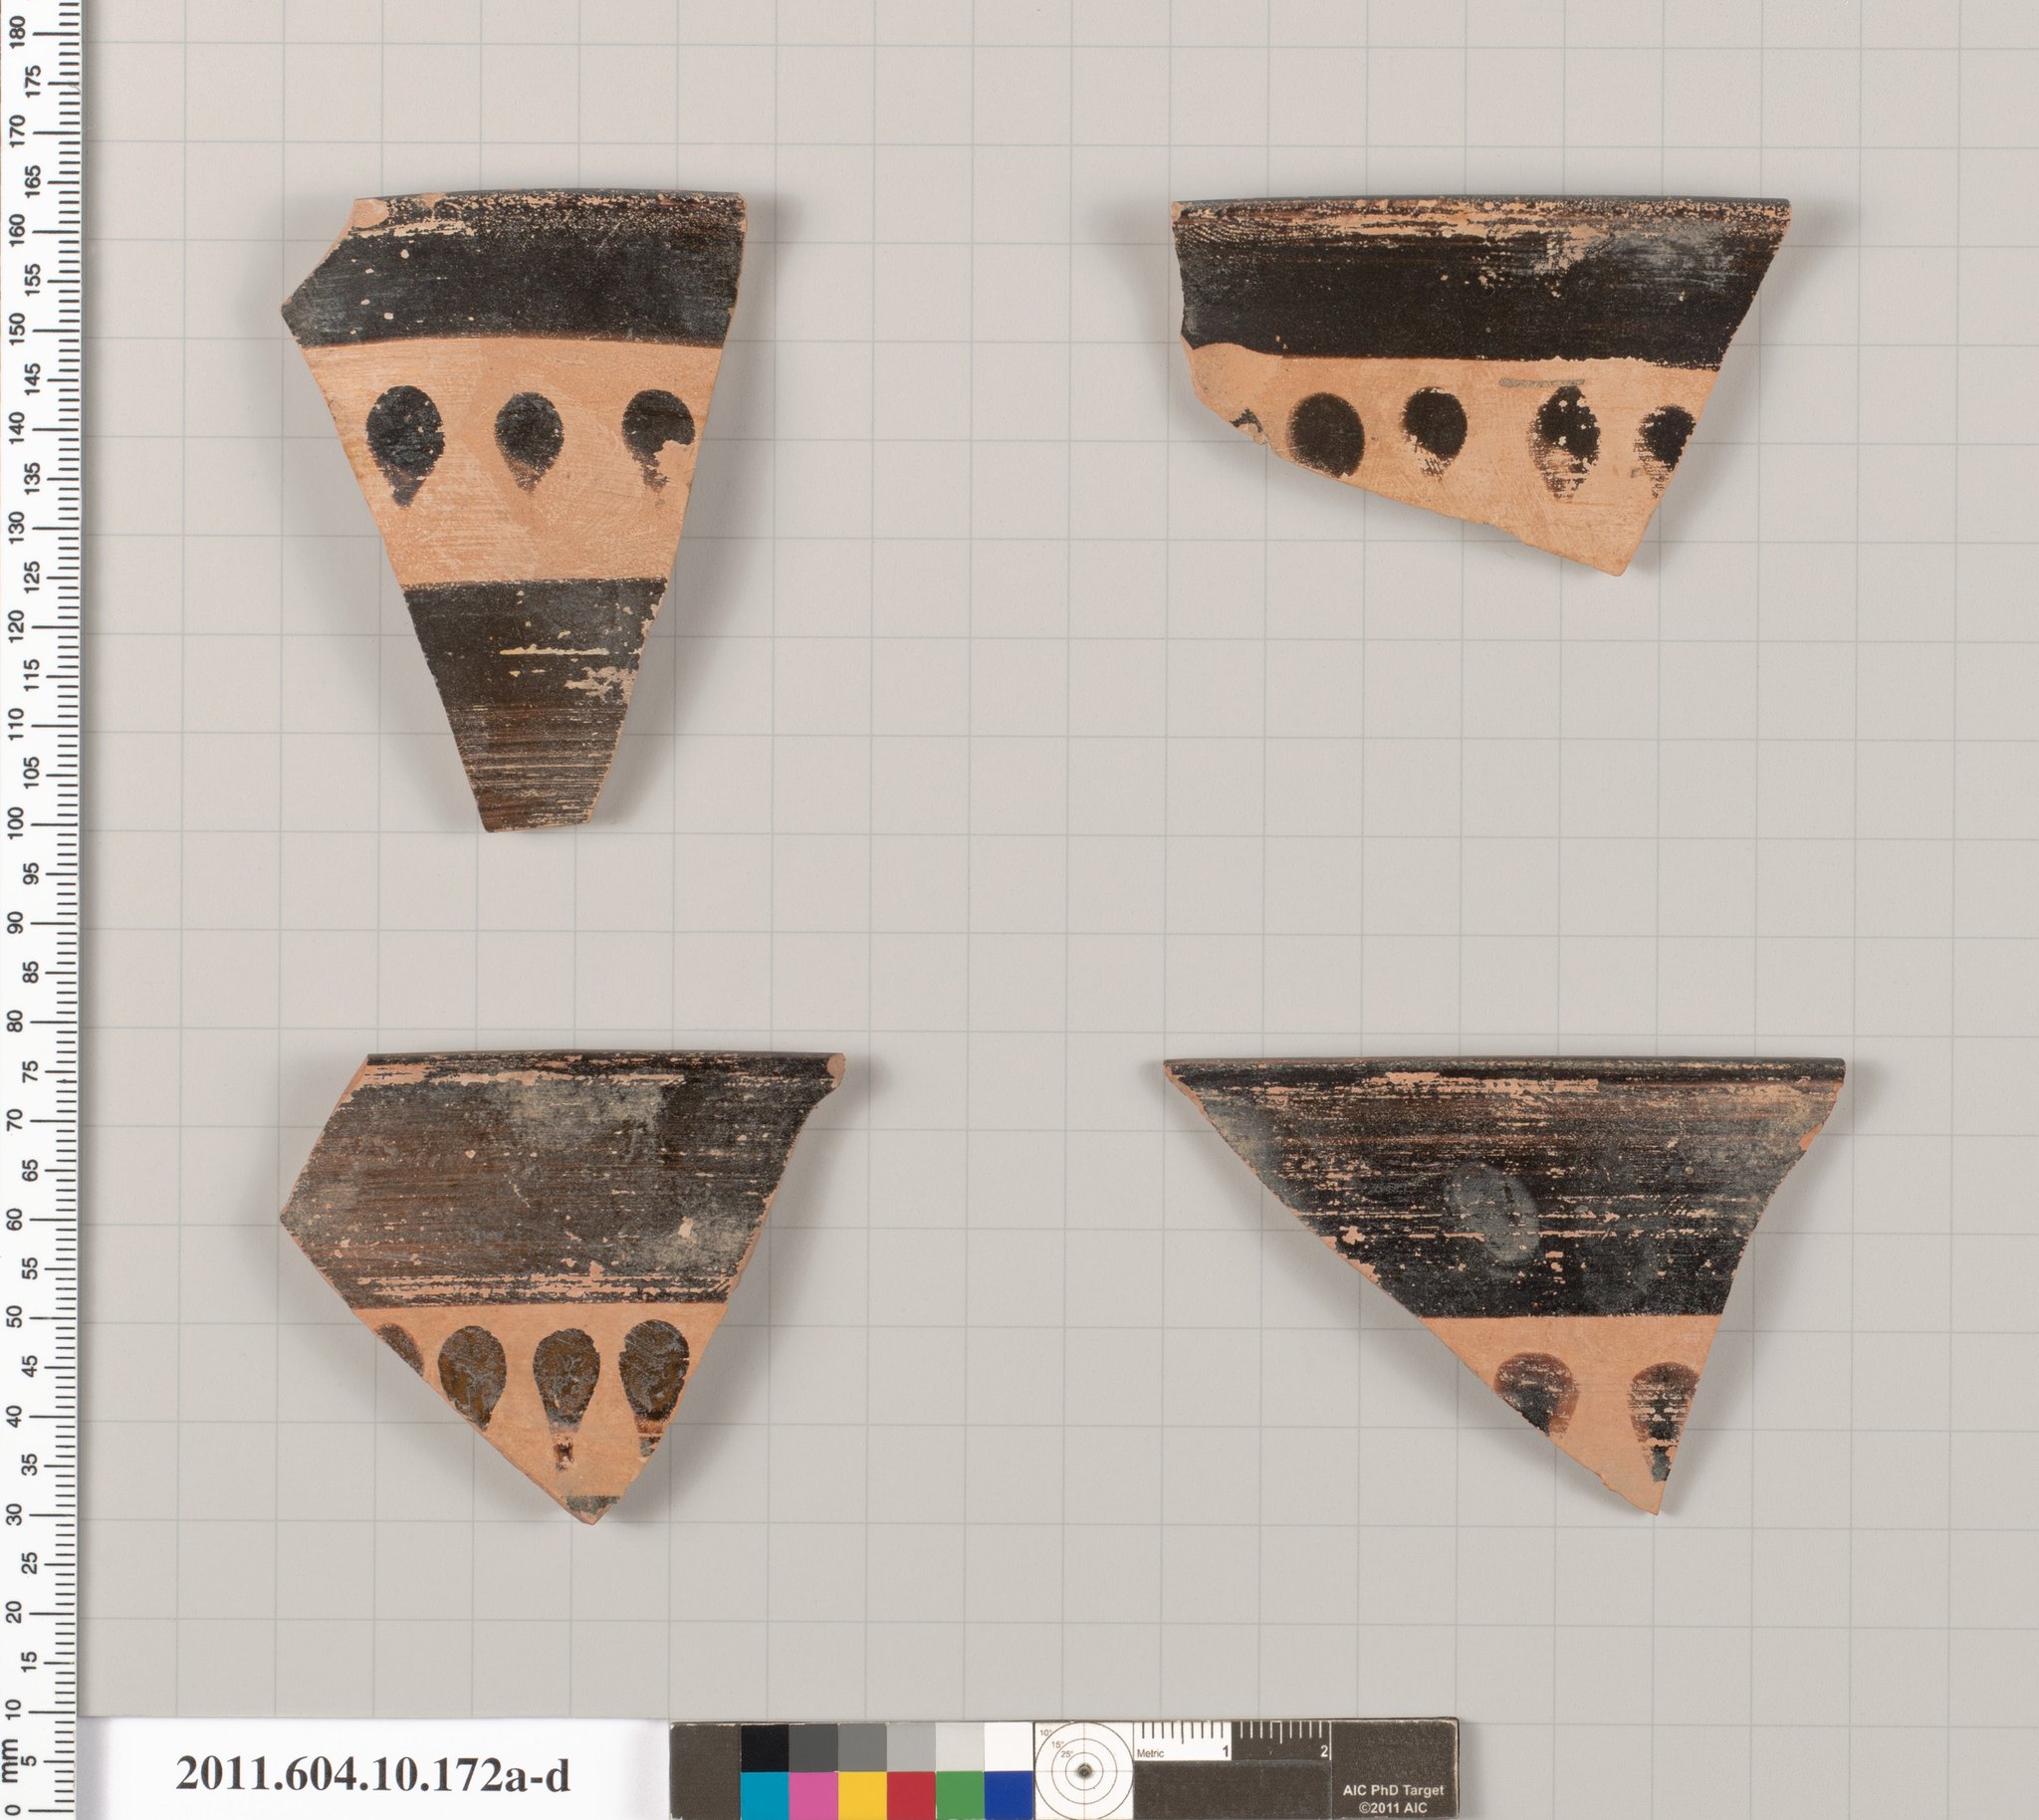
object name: skyphos fragment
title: Terracotta rim fragments of a skyphos (deep drinking cup)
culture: etruscan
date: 534-468 BCE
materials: terracotta